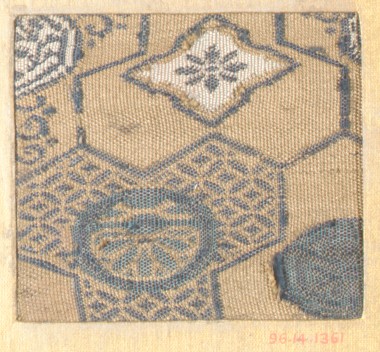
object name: piece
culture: japanese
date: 1701-1900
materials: silk